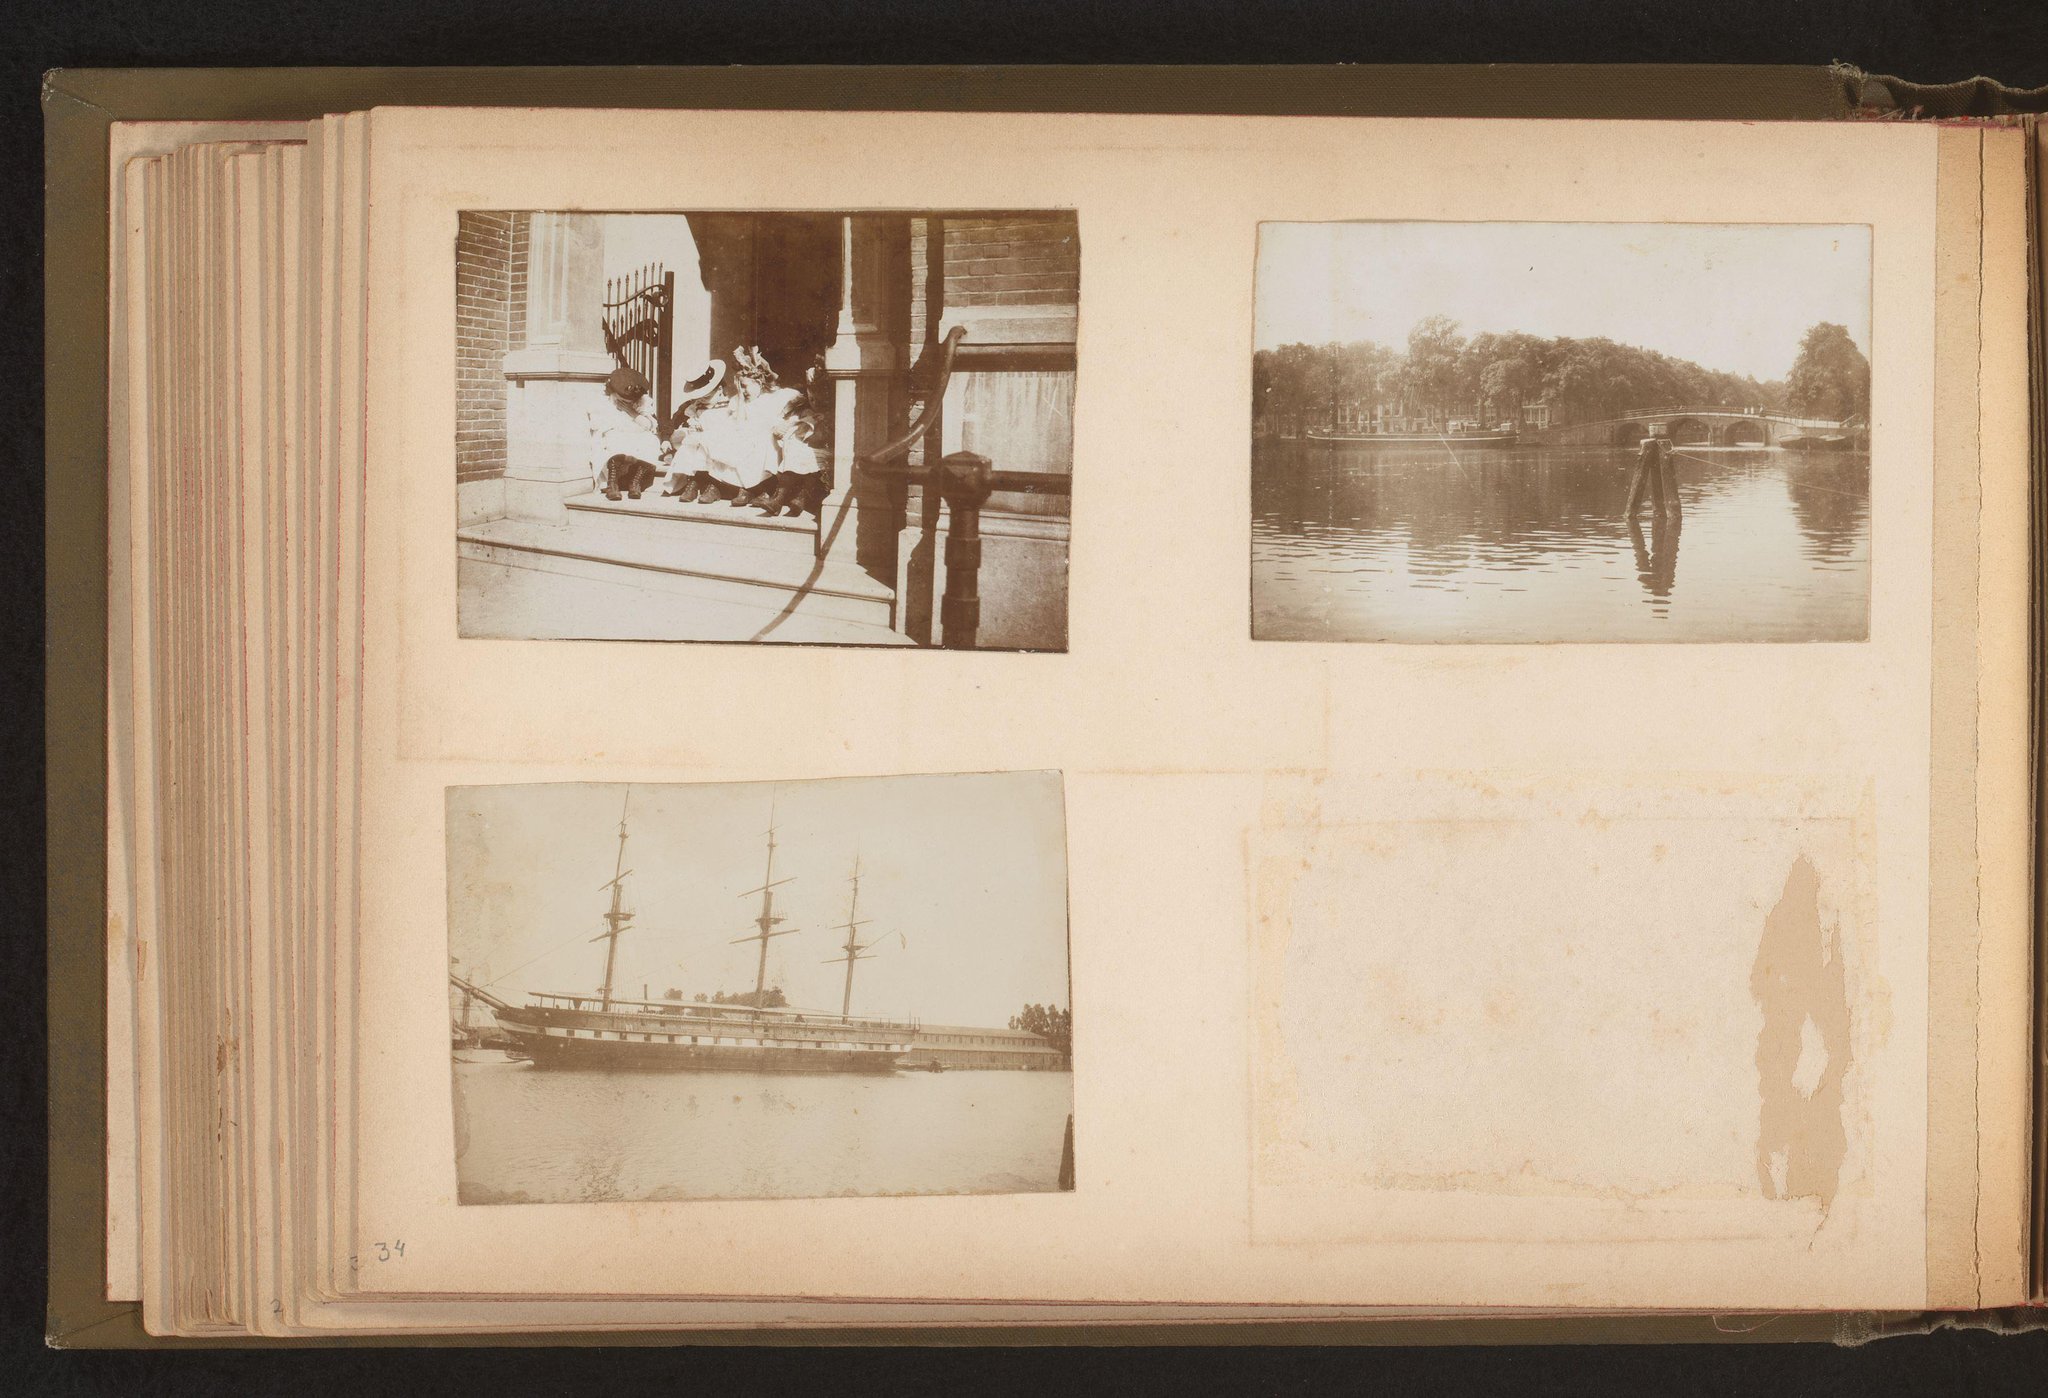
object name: album leaf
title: Drie foto's van Amsterdam, kinderen op een stoep, een gracht en een zeilschip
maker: Anonymous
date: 1895-1910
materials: paper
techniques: collodion silver print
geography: amsterdam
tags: sailing-ship, sailing-boat, child, canals, waters (in city), amsterdam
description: Deze foto's maken deel uit van een album.